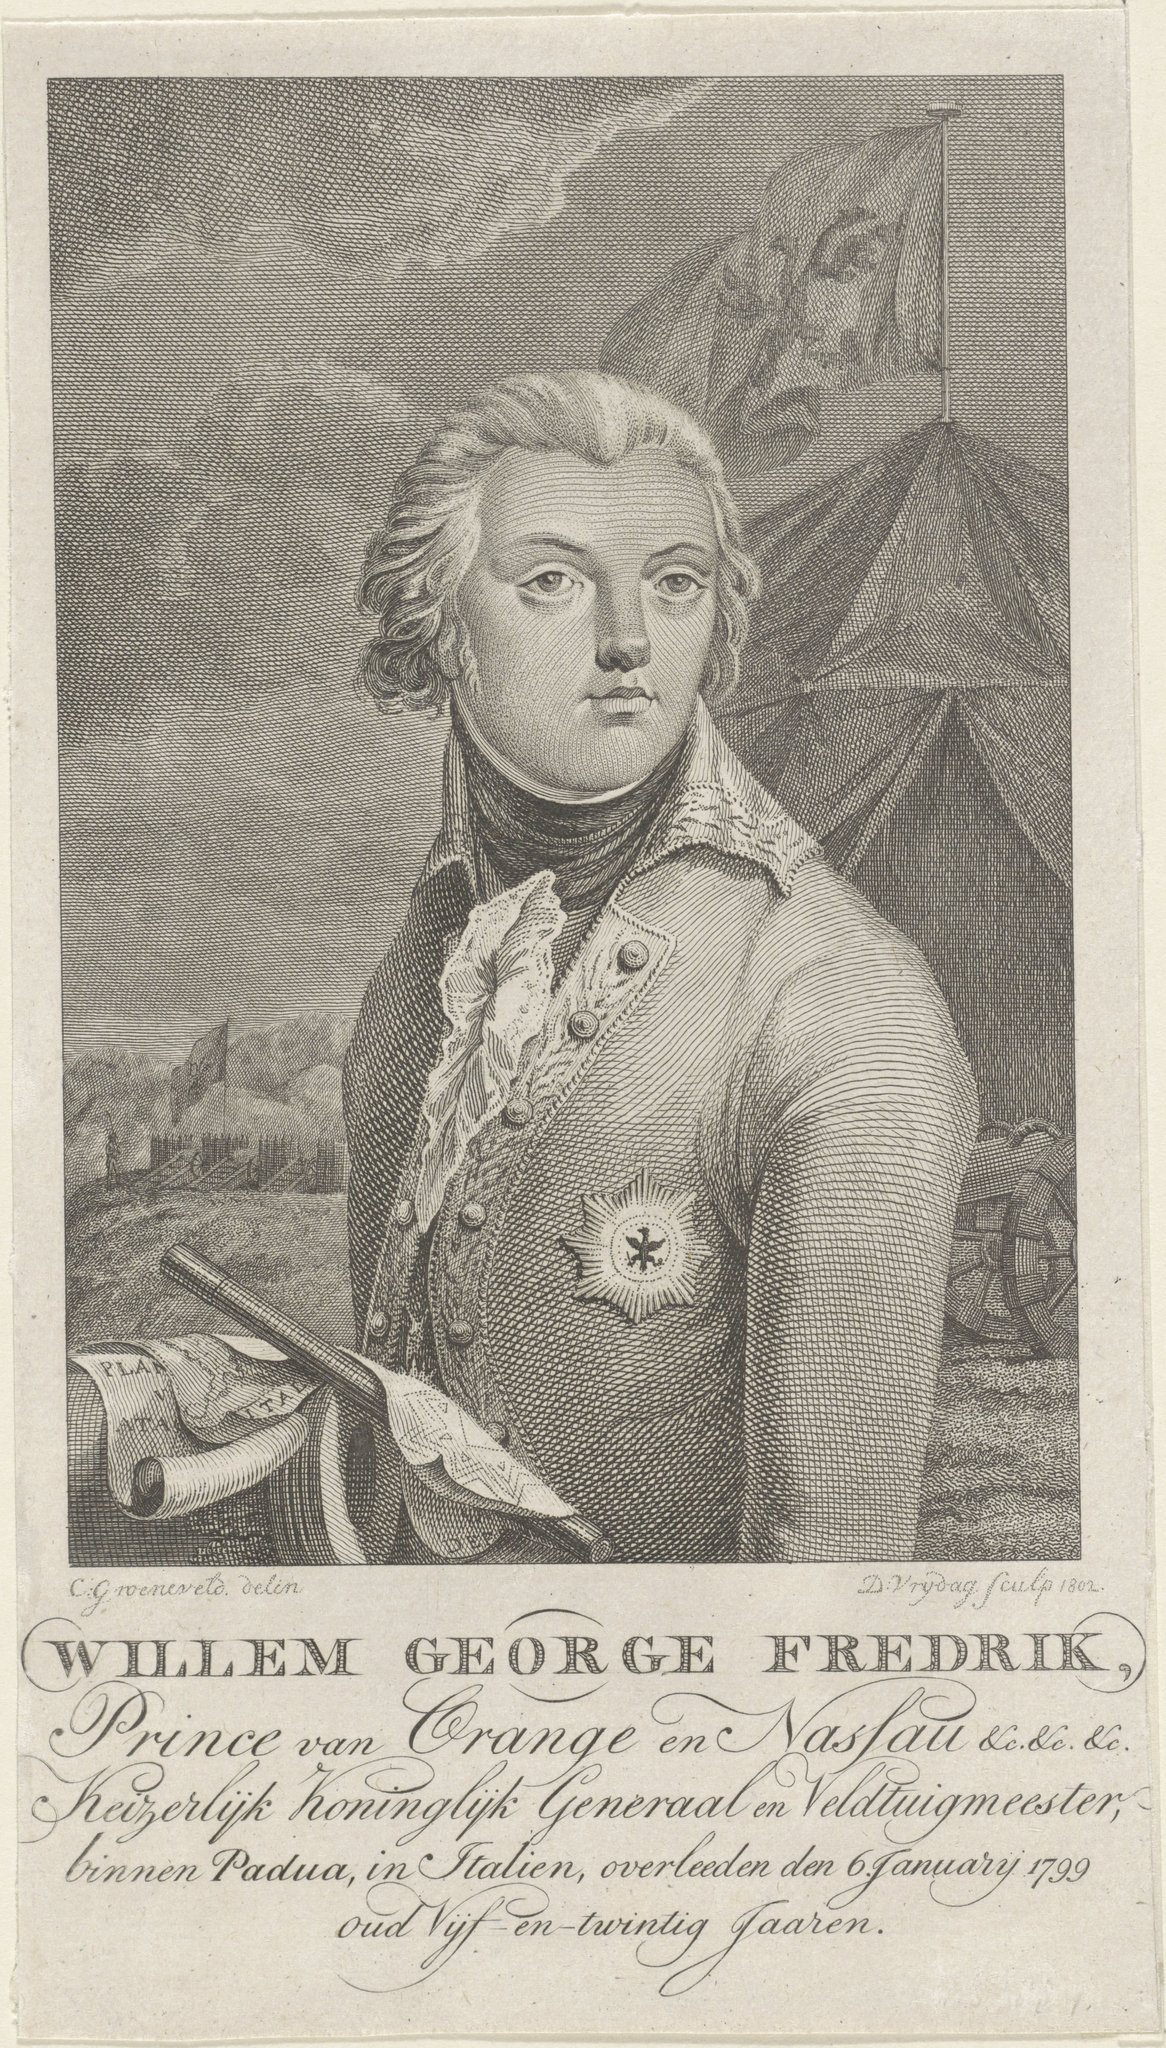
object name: print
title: Portret van Frederik, prins van Oranje-Nassau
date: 1802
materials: paper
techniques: engraving, etching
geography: northern netherlands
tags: the hague, willem george frederik (prins van oranje-nassau), knighthood order (with name) - insignia of a knighthood order, e.g.: badge, chain (with name of order)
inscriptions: collector's mark: Lugt 2166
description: De hier vermelde titel verwijst naar de hoogst verkregen titel van de geportretteerde, niet per se naar de titel die de geportretteerde op deze voorstelling draagt.